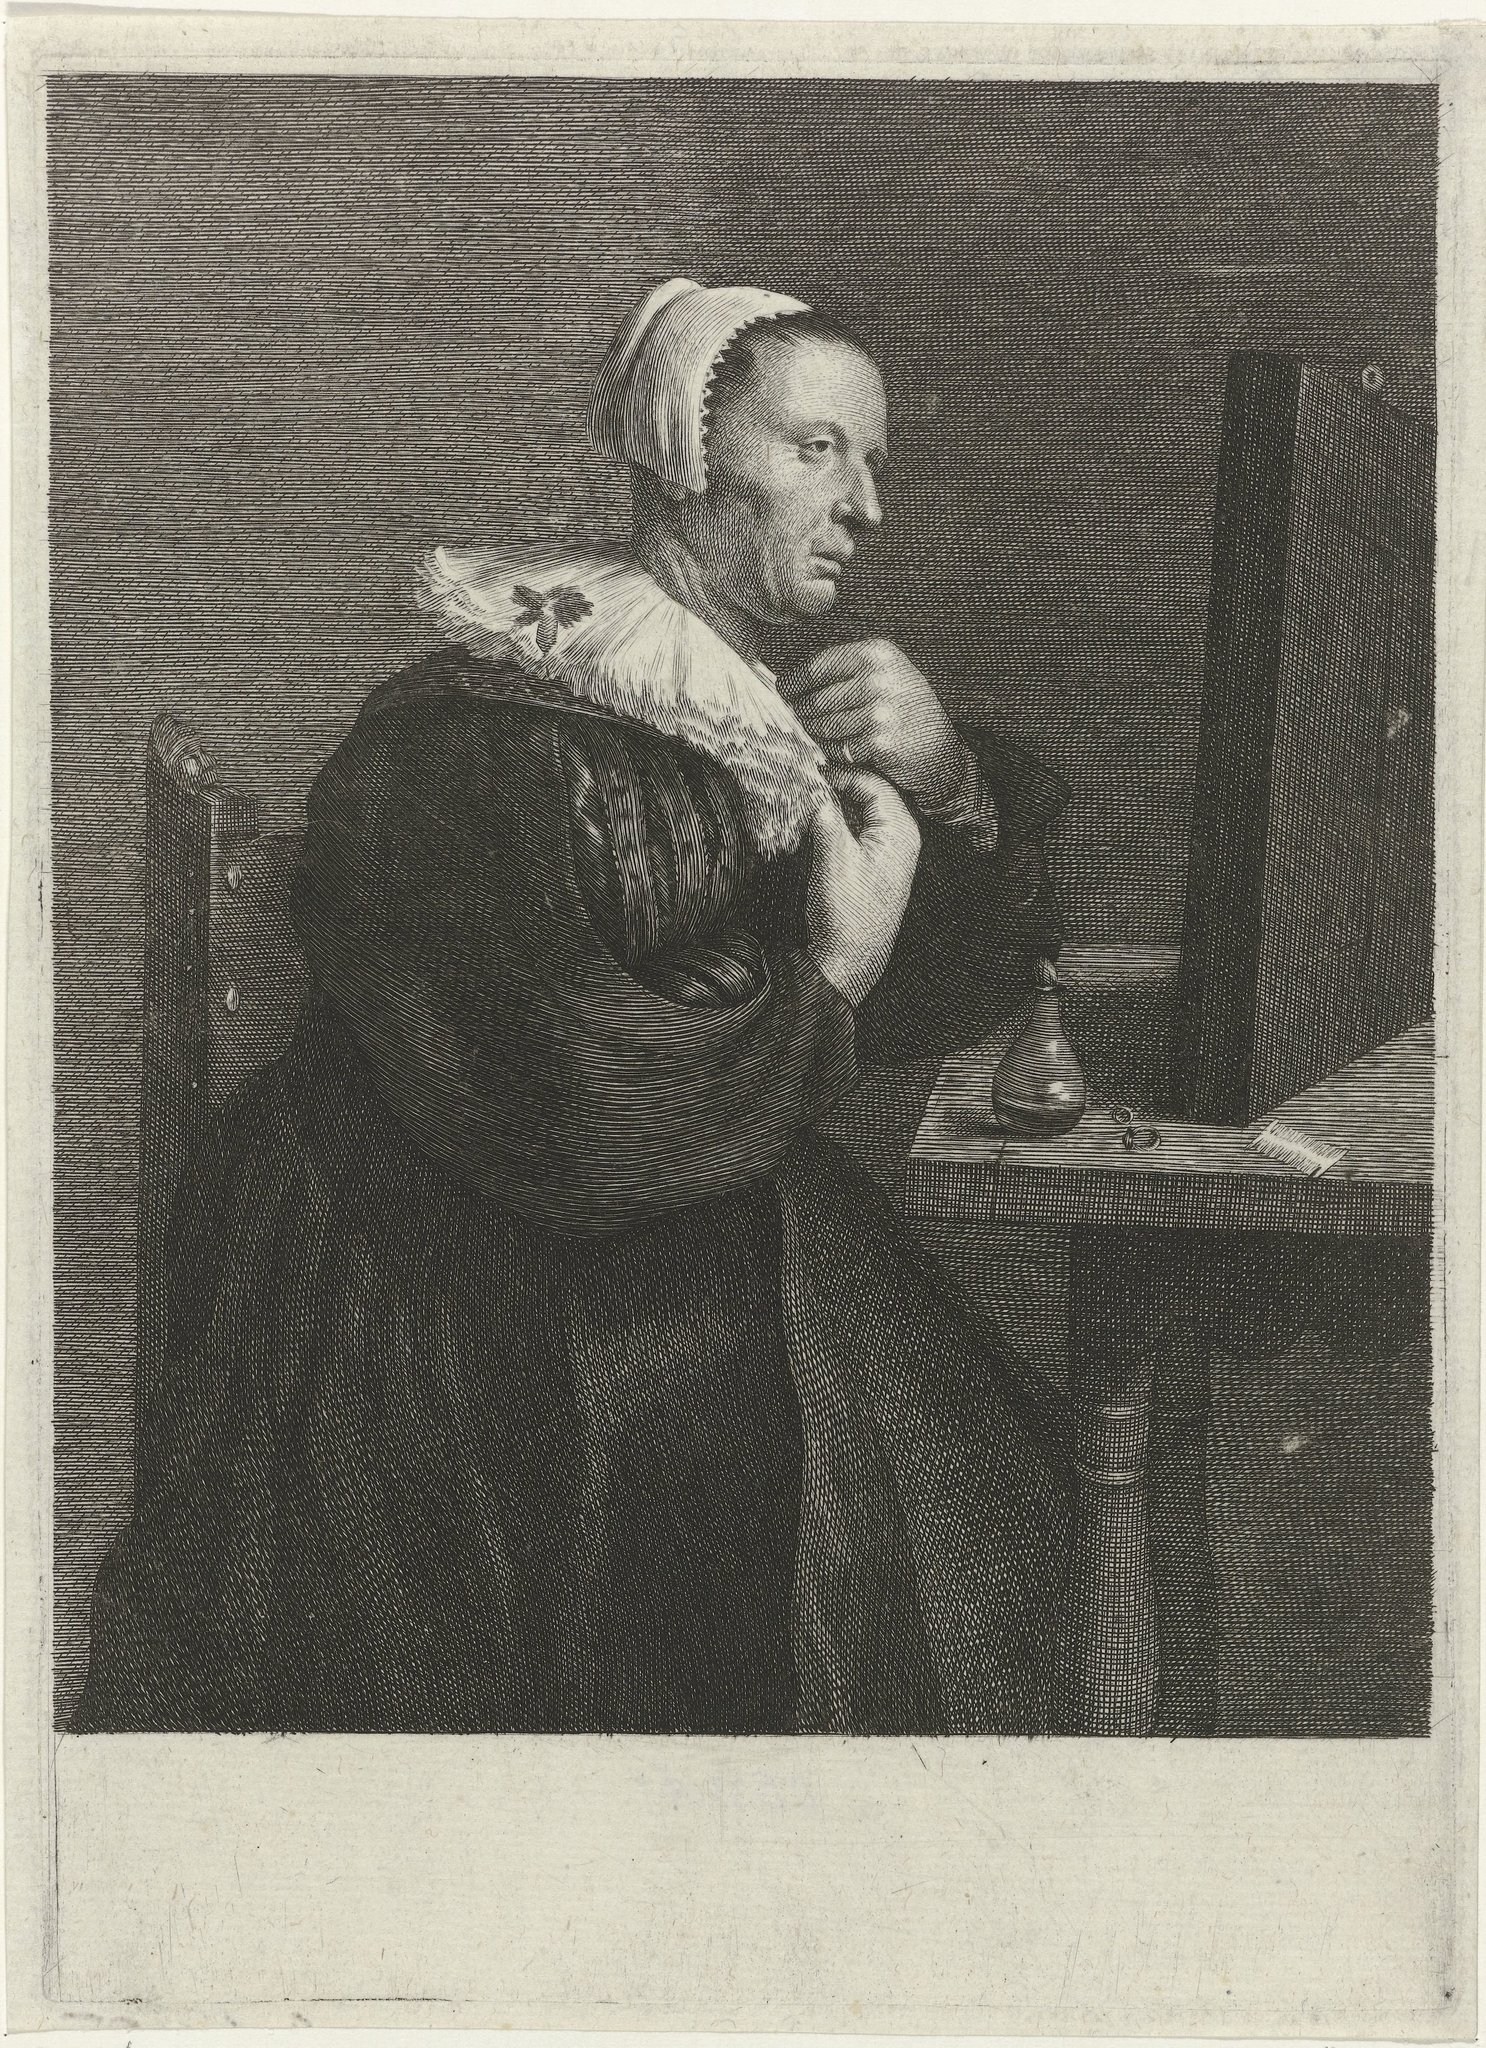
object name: print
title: De zeven hoofdzonden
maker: lucas vorsterman (i)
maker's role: print maker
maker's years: 1595-1675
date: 1619-1675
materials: paper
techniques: engraving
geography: antwerp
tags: perfume bottle - aa - (for) women, pride; 'superbia' (ripa) ~ personification of one of the seven deadly sins, old woman, making toilet - aa - (for) women, neck-gear: collar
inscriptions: collector's mark: Lugt 240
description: Een oude vrouw zit voor een spiegel en maakt haar kraag vast. Op de tafel liggen twee ringen en een kam naast een parfumflesje.